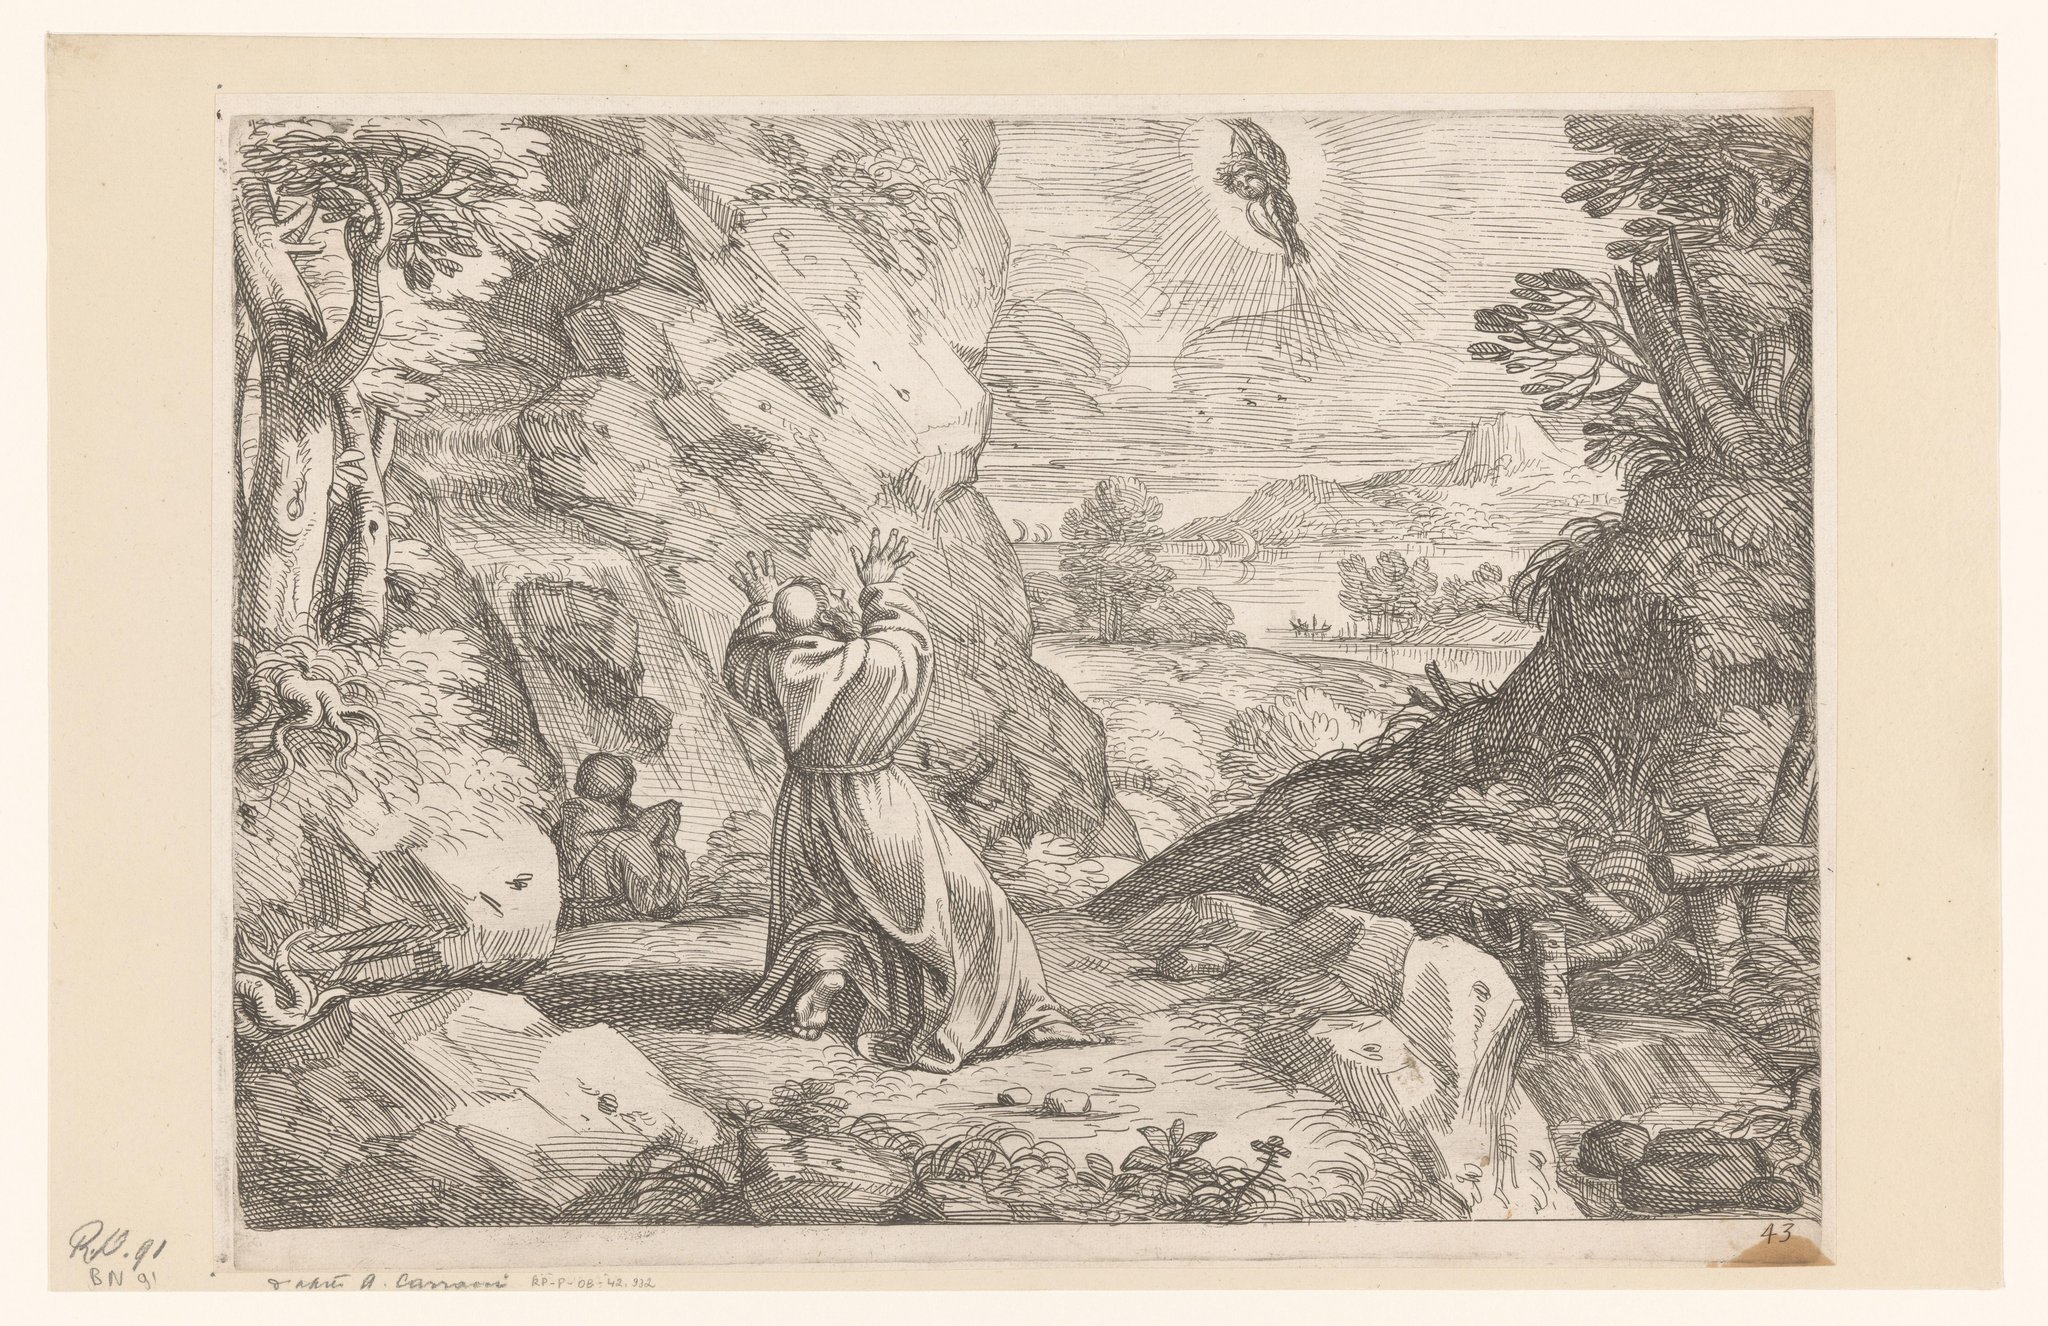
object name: print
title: Prenten naar tekeningen uit het kabinet Jabach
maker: michel corneille (ii)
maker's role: painter, print maker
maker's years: 1642-1708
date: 1652-1708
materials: paper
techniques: engraving, etching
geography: france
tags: stigmatization, stigmata, founder of the order of friars minor (franciscans), francis(cus) of assisi; possible attributes: book, crucifix, lily, skull, stigmata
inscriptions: collector's mark: Lugt 240